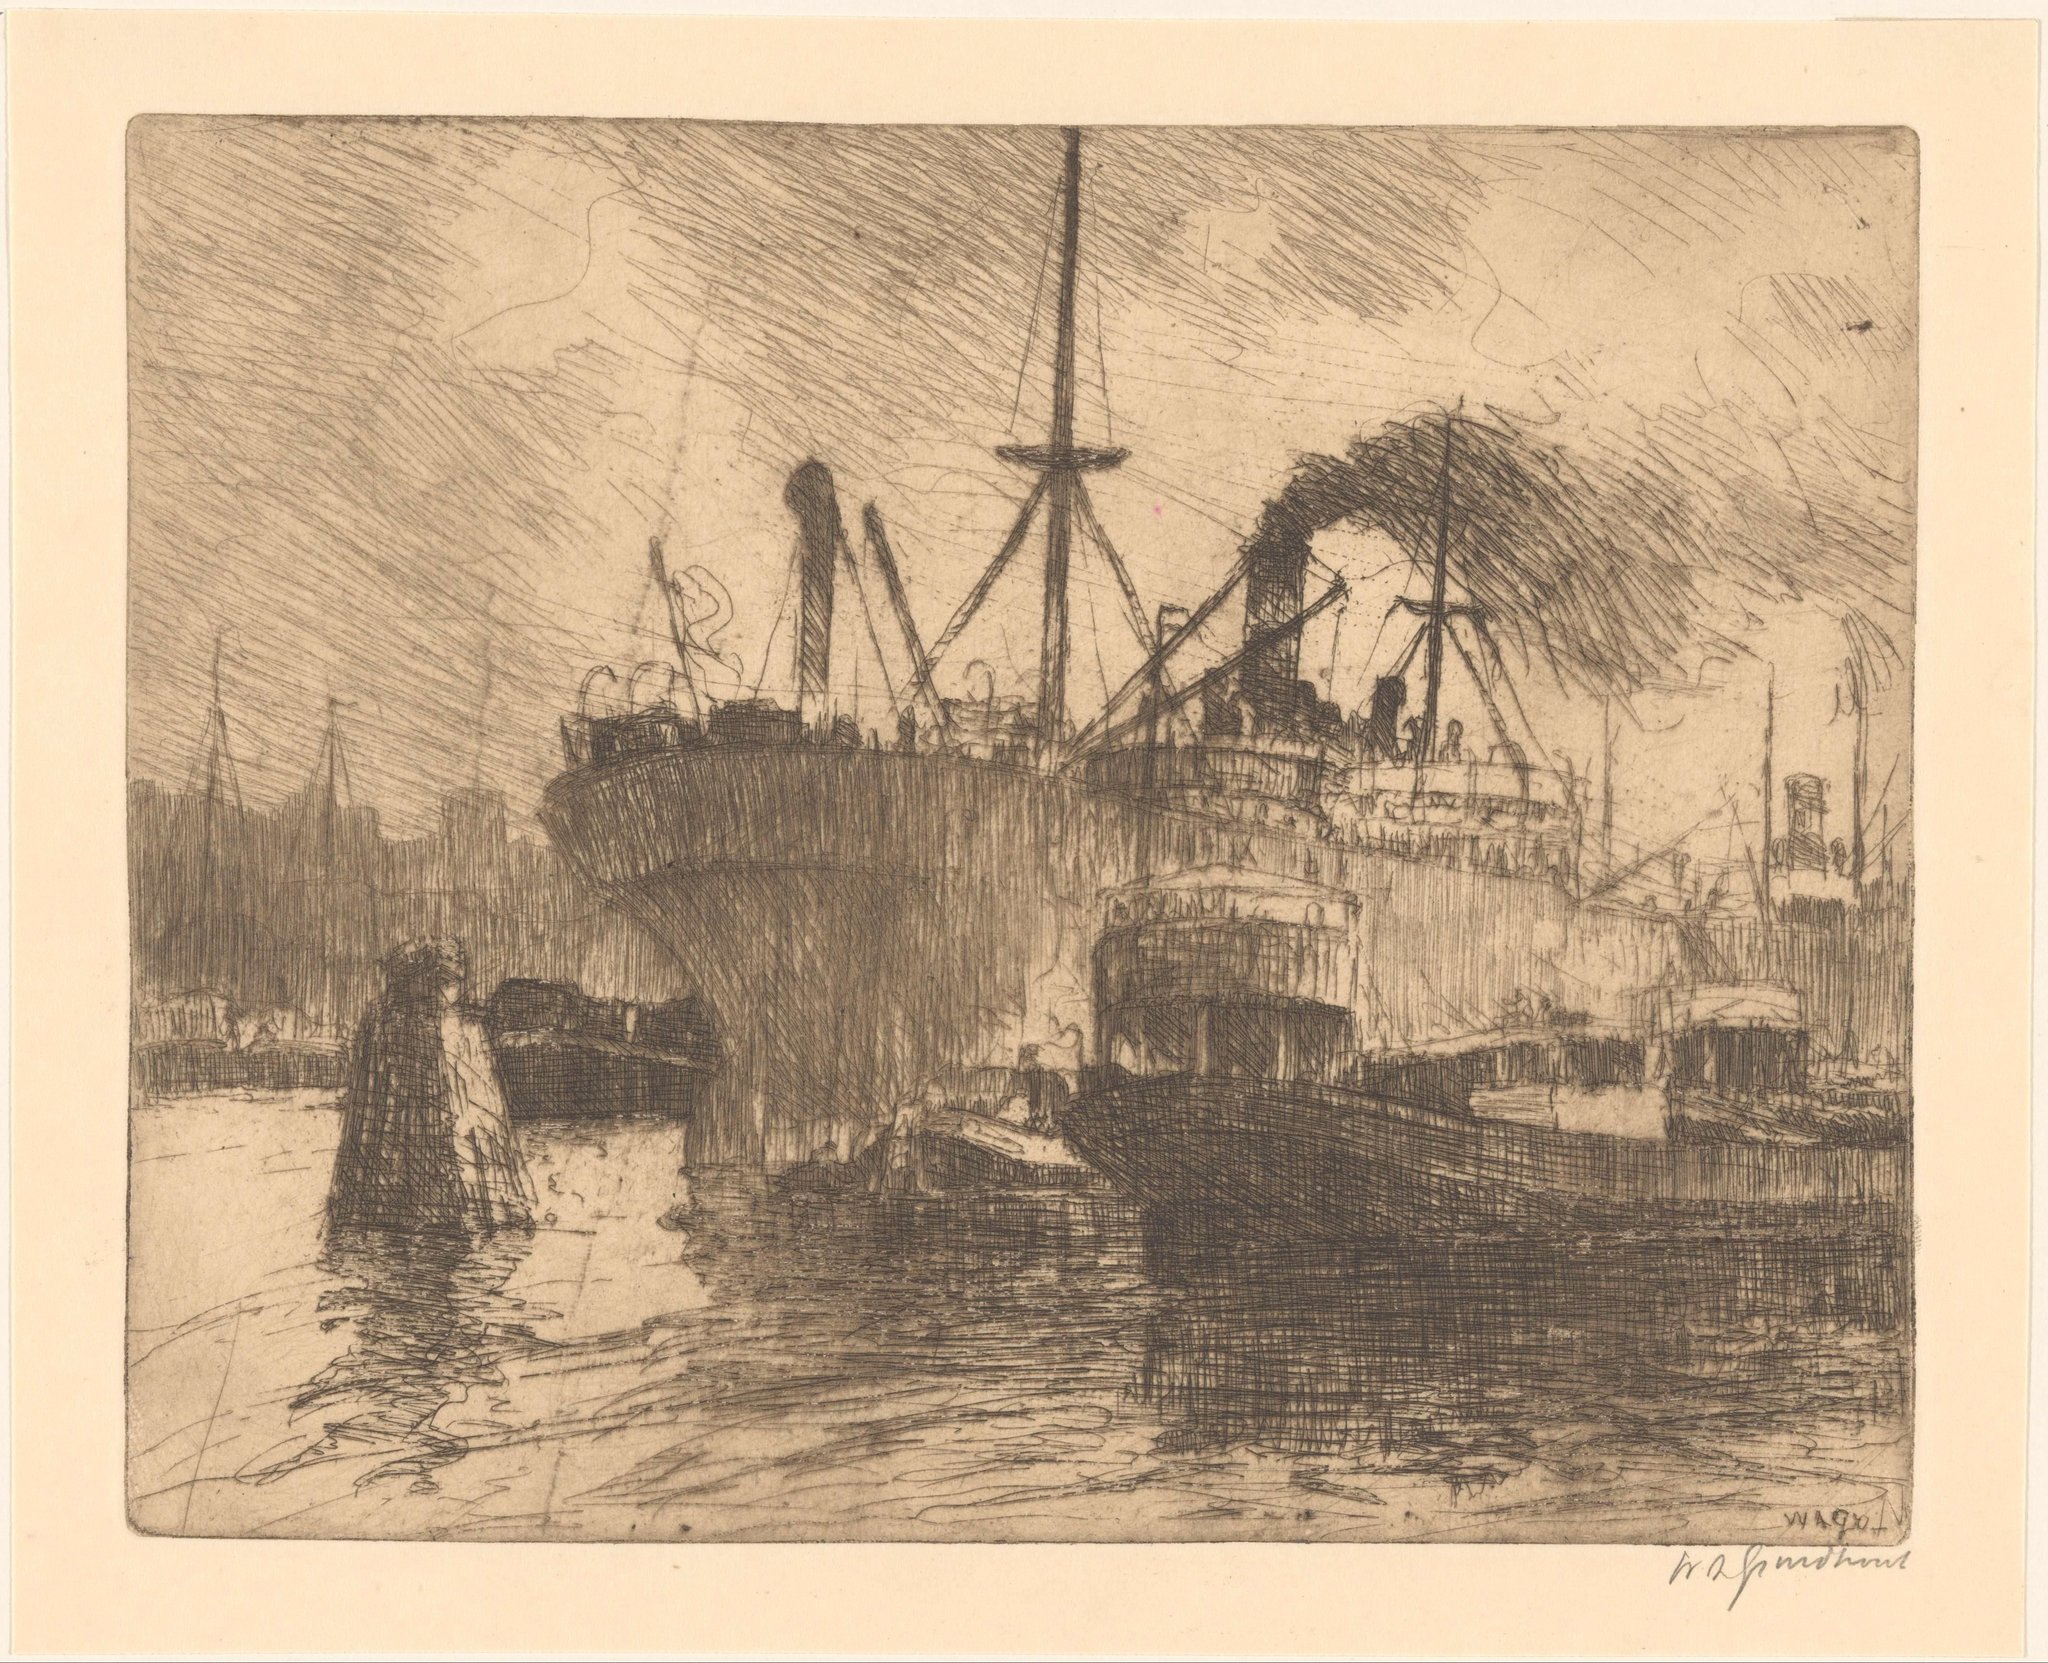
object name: print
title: Afgemeerde schepen in de haven van Rotterdam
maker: willem adrianus grondhout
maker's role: draughtsman, painter, print maker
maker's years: 1878-1934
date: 1888-1931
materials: paper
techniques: etching, intaglio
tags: harbour, rotterdam